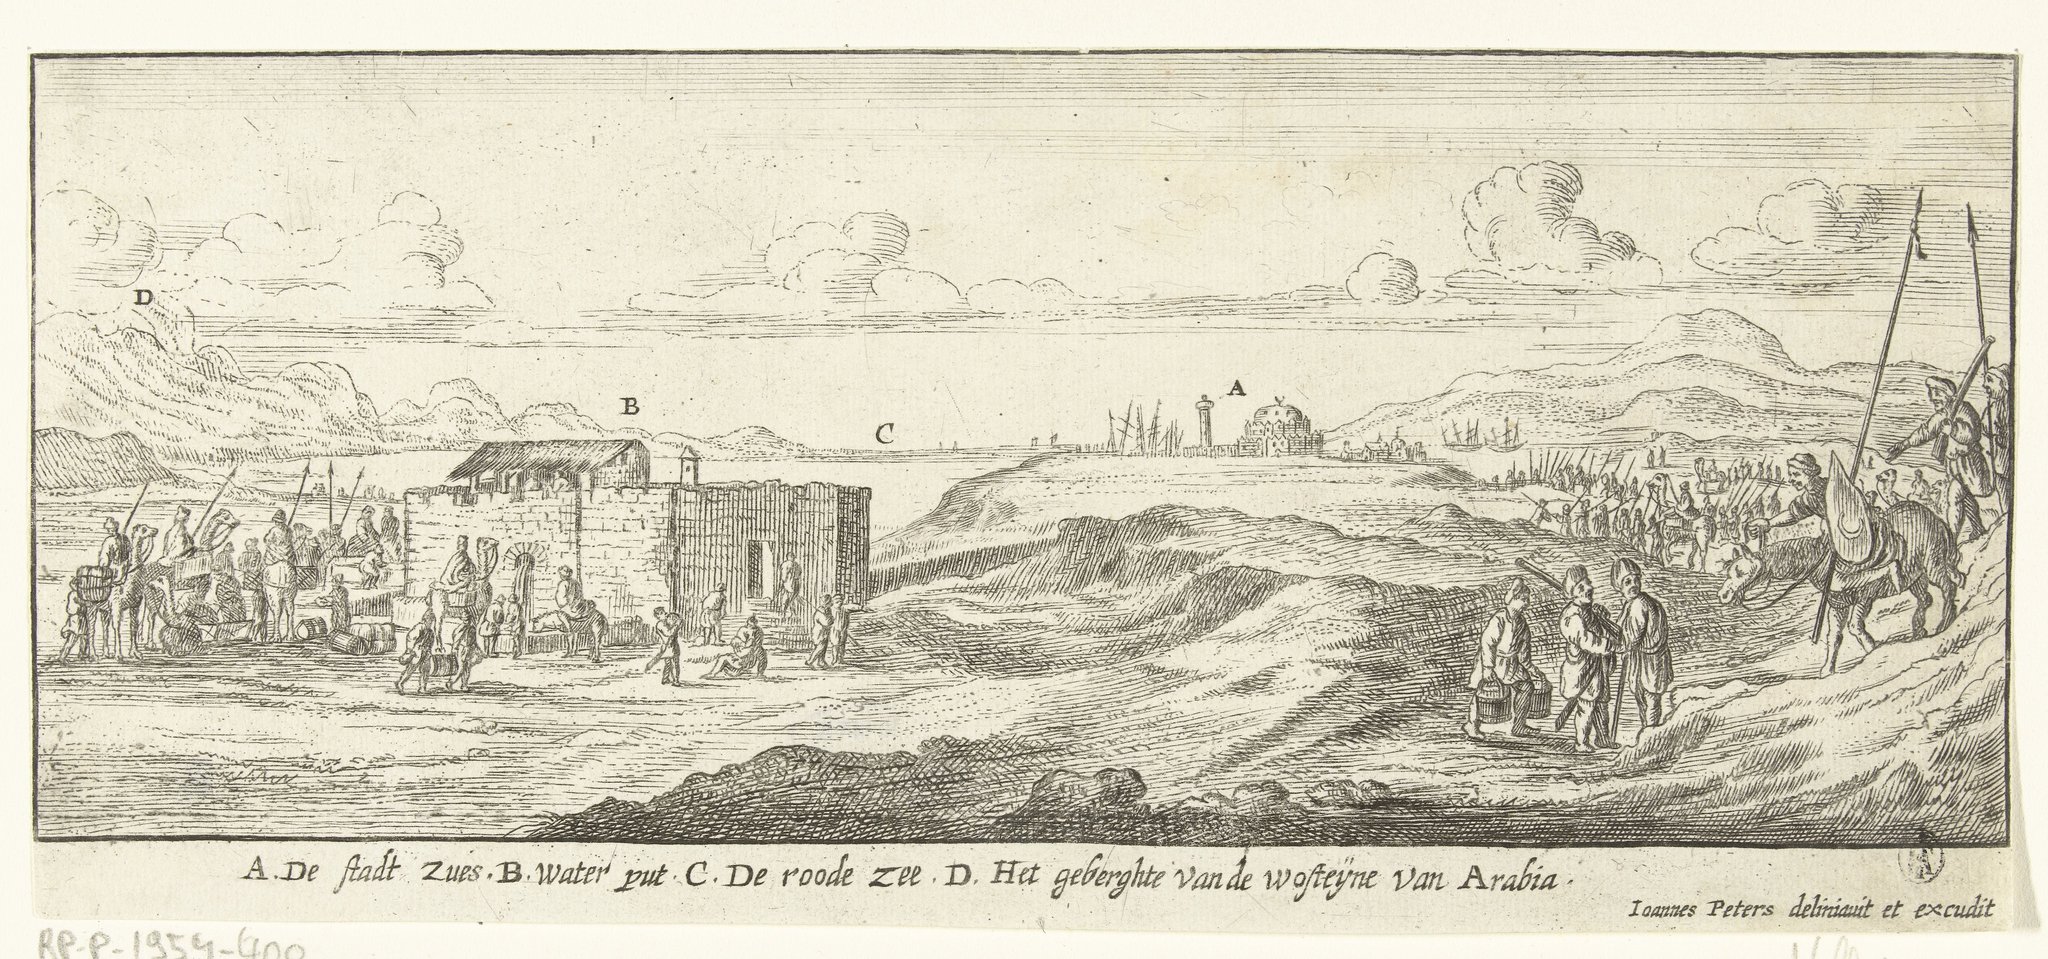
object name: print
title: Gezicht op Suez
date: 1672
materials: paper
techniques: etching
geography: antwerp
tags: spring, source of river or stream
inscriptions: collector's mark: Lugt 971, collector's mark: Lugt 2760, collector's mark: Lugt 2228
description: Gezicht op de stad Suez. Op de achtergrond de Rode Zee. Op de voorgrond een waterput waar een karavaan zich bevoorraadt. De prent heeft een Nederlands onderschrift met verwijzingen naar gebouwen en plaatsen op de prent.